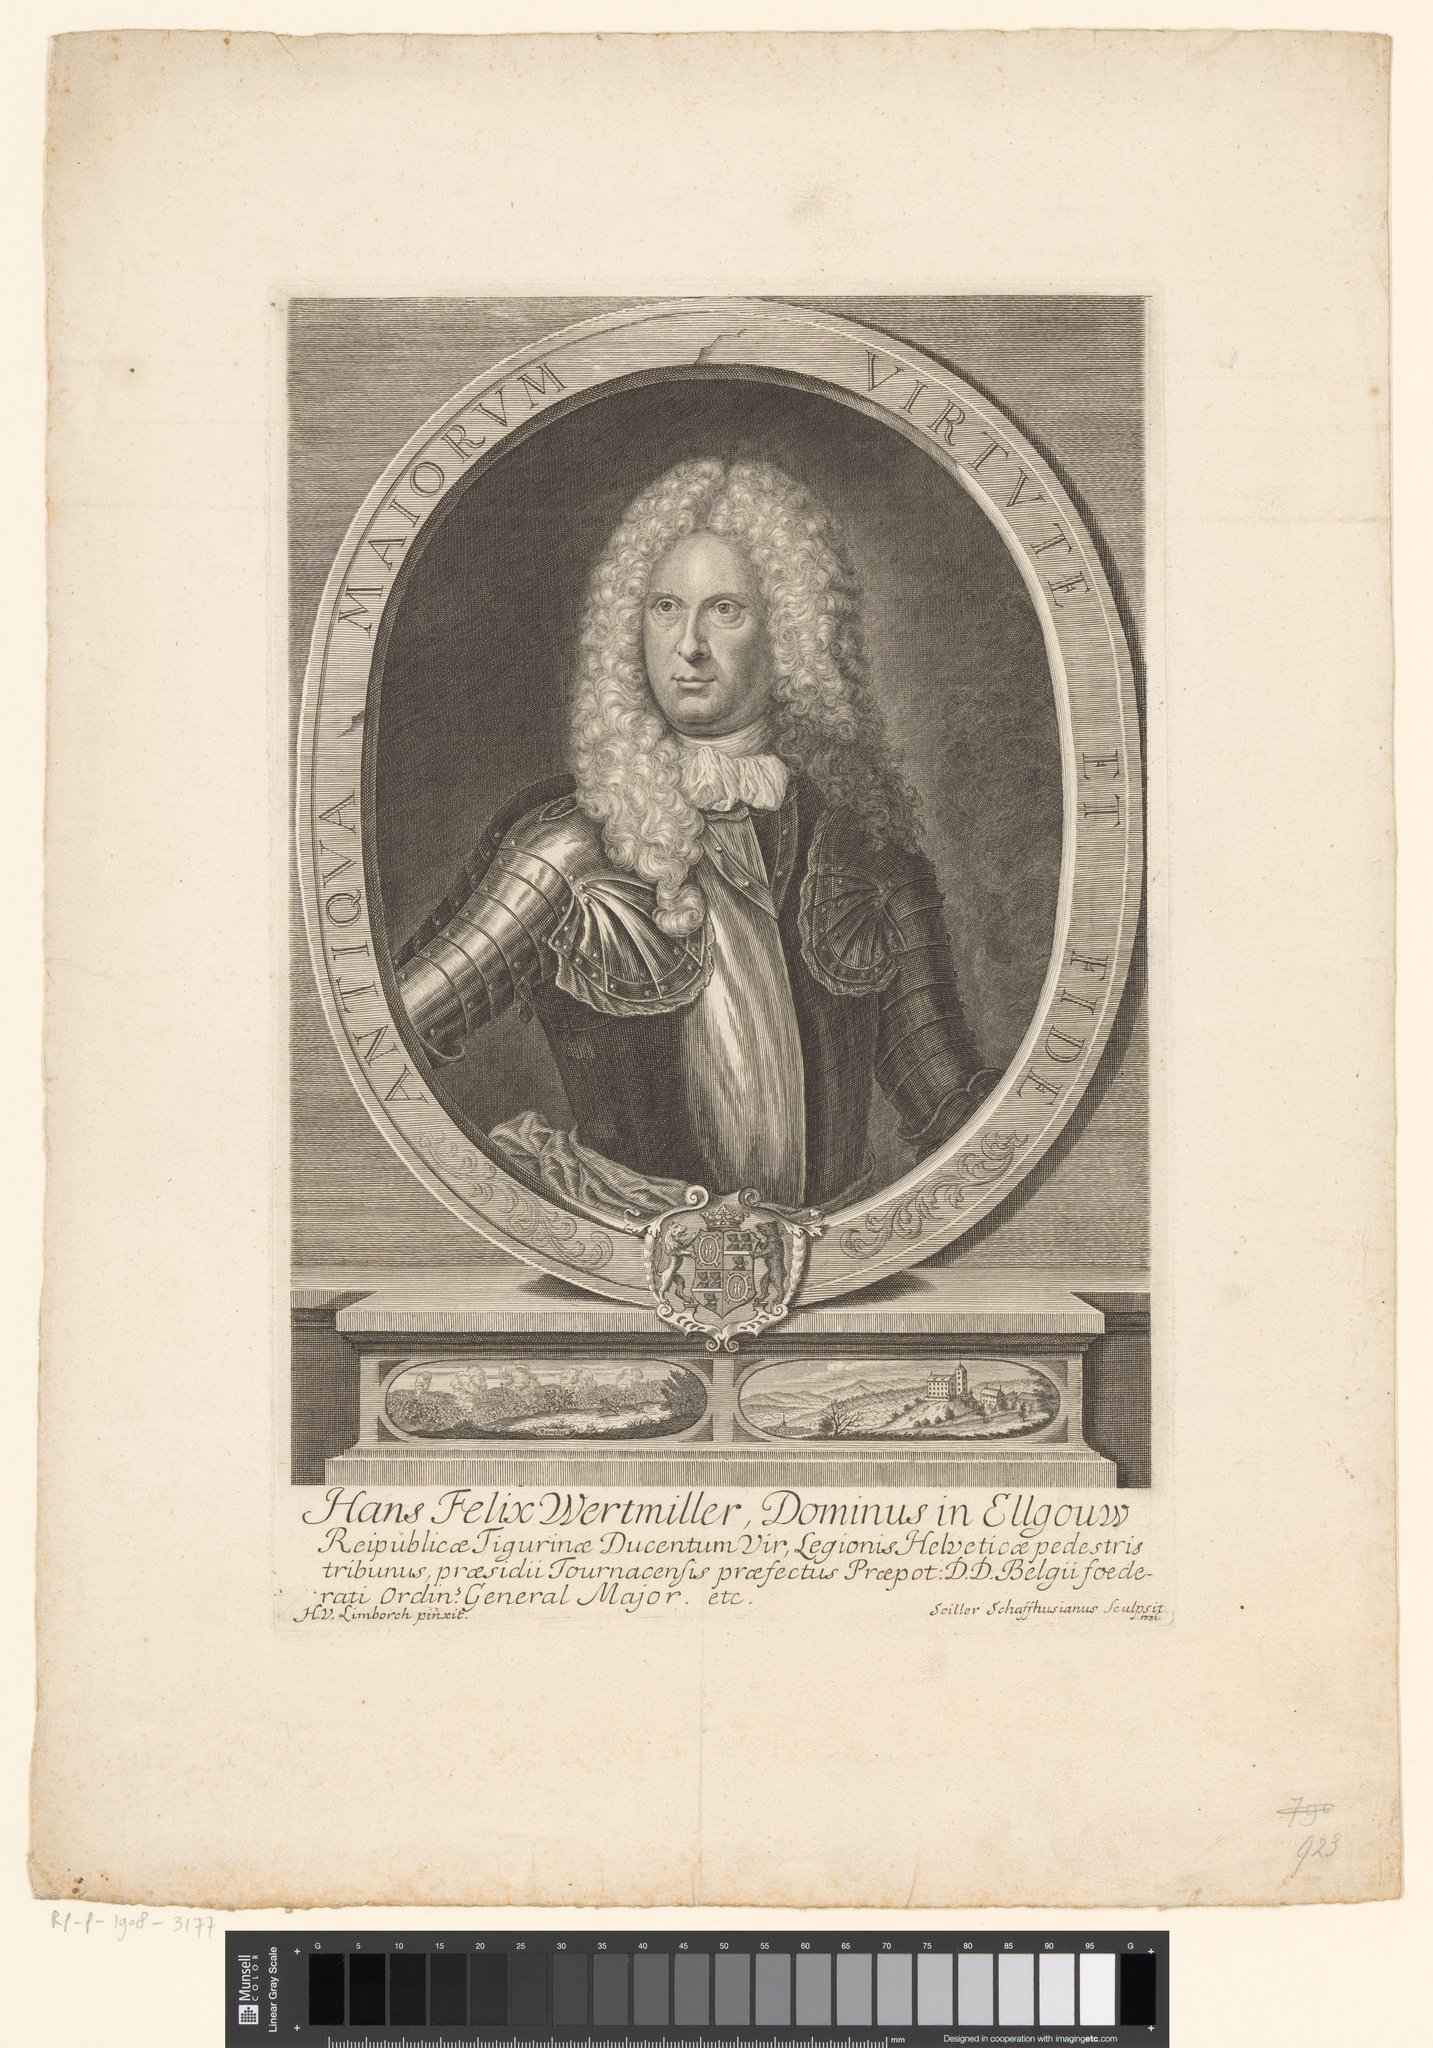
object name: print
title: Portret van Hans Felix Werdmüller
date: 1731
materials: paper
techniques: engraving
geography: schaffhausen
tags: castle, armour, historical persons, battle, armorial bearing, heraldry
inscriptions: collector's mark: Lugt 2228